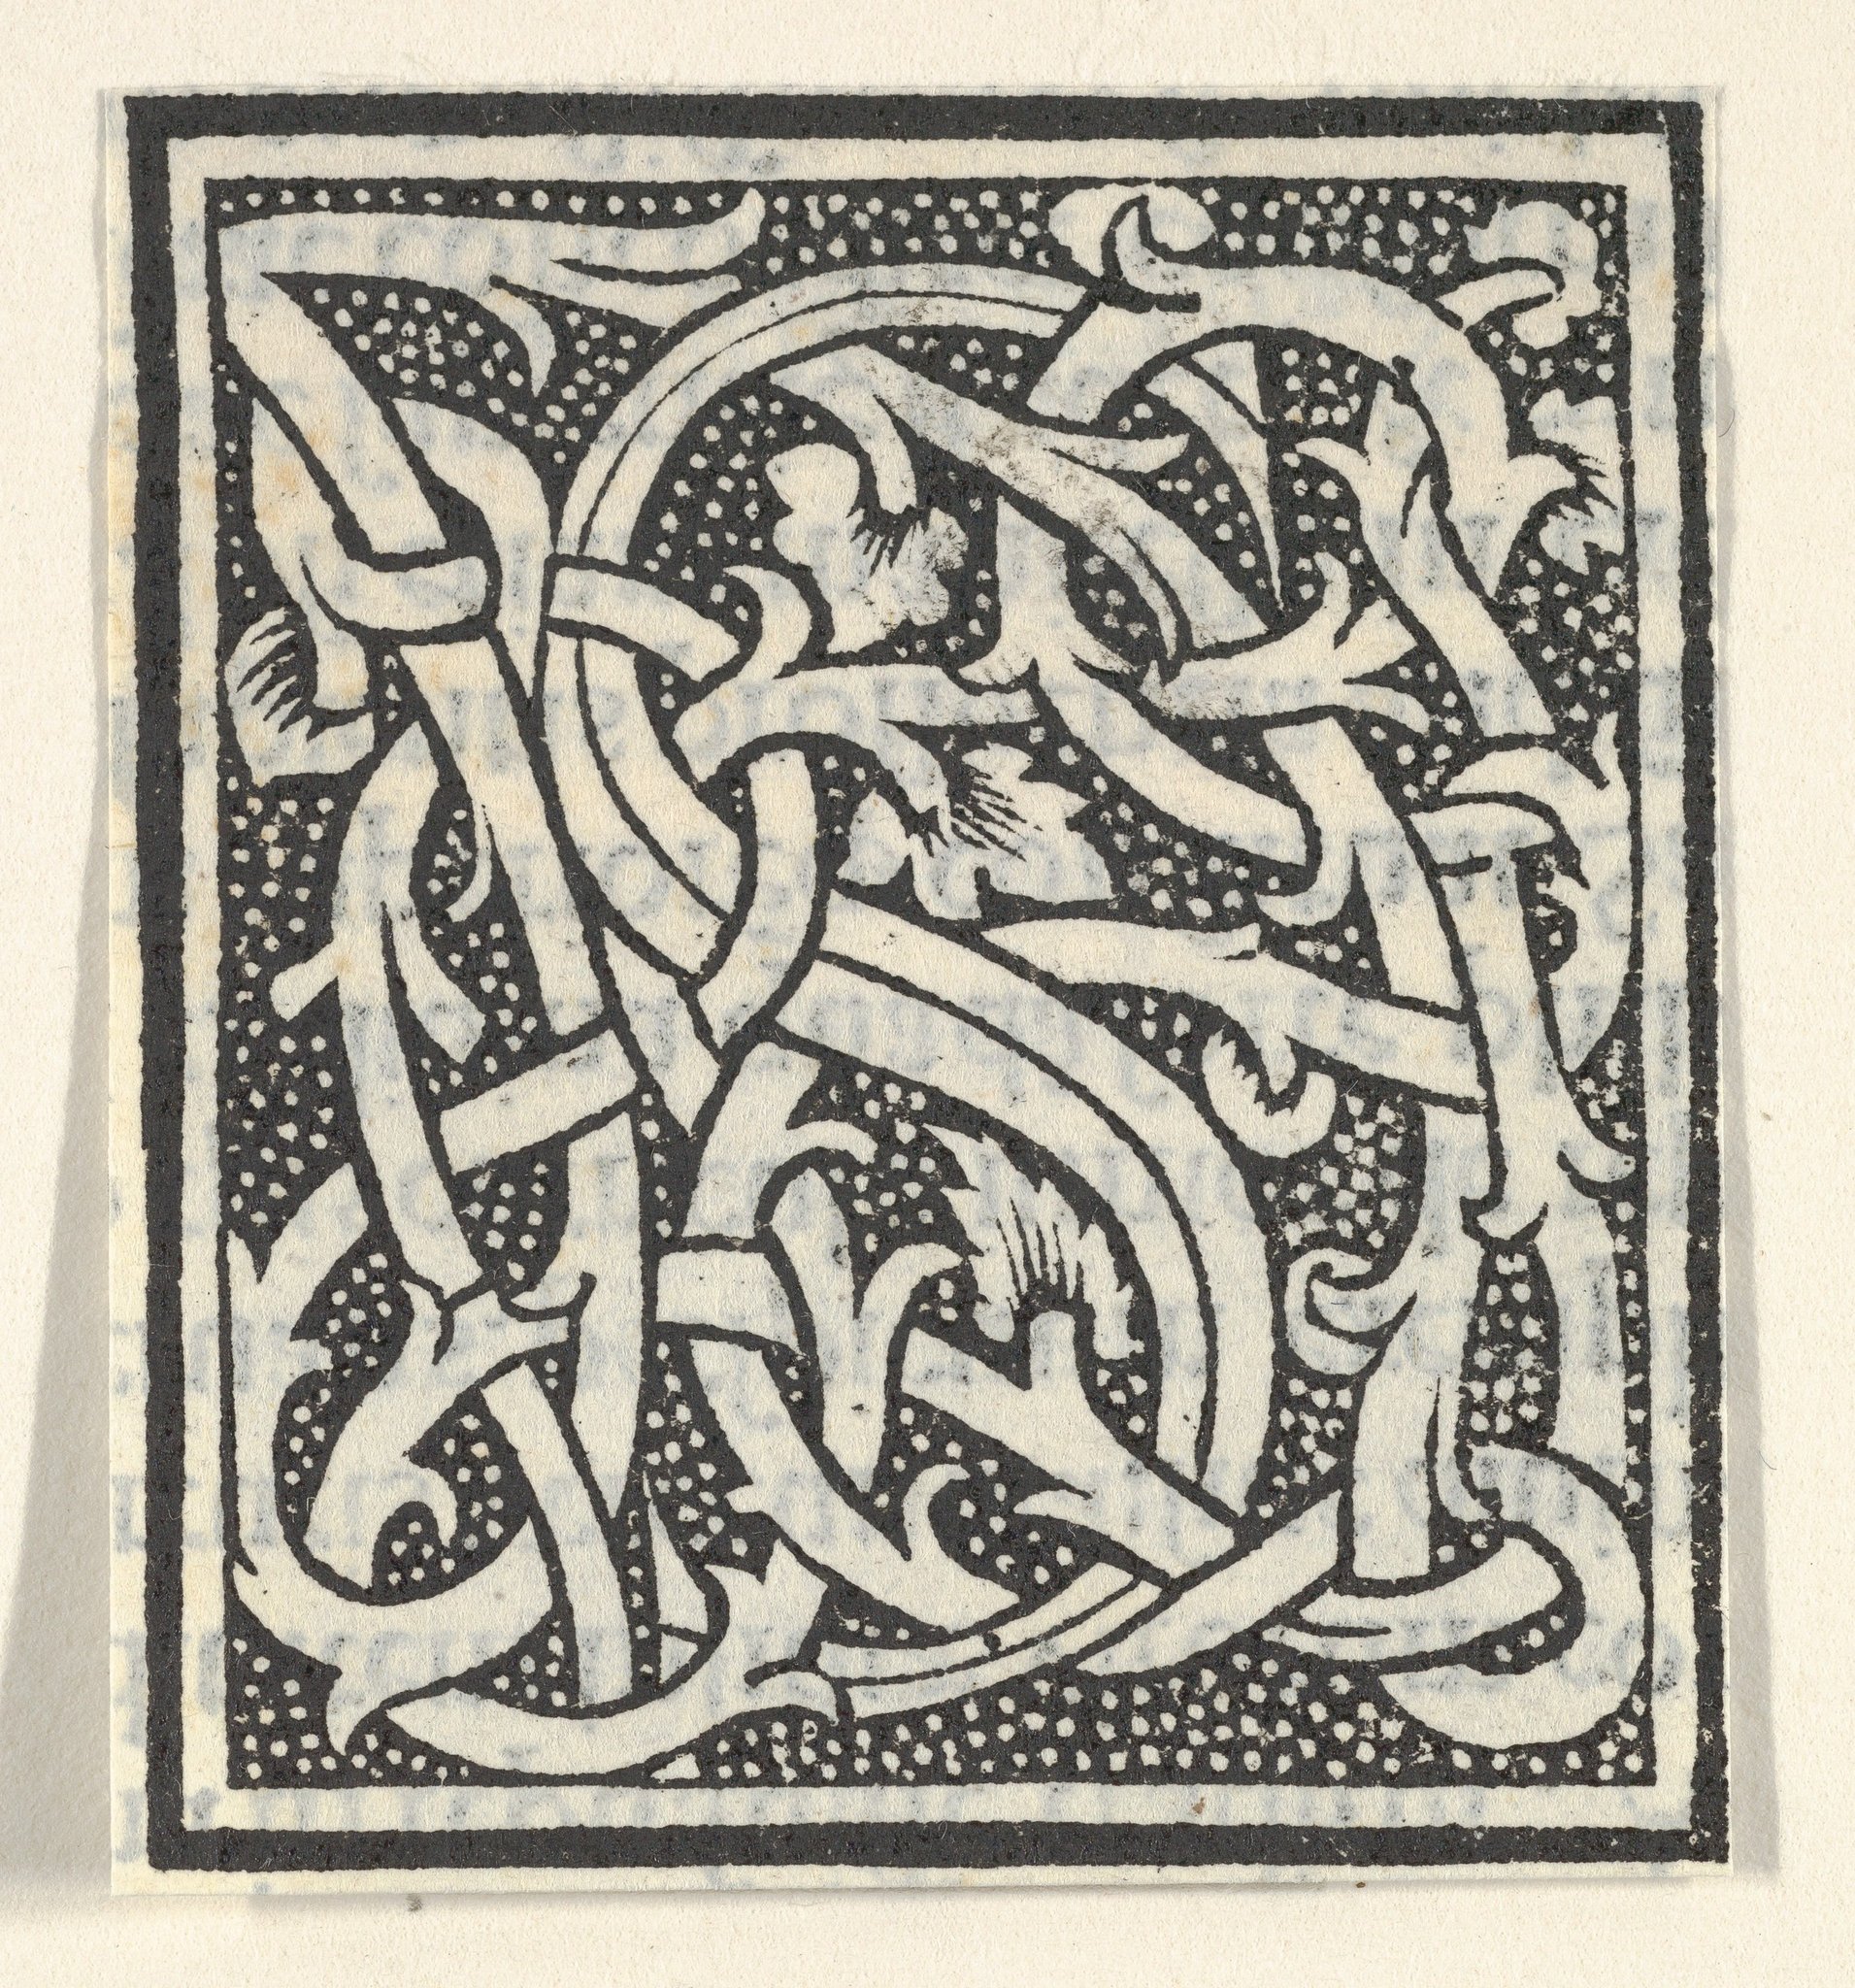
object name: print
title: Initial letter S on patterned background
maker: anonymous, italian, 16th century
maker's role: artist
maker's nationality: italian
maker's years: 1500-1600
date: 1520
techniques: woodcut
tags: leaves